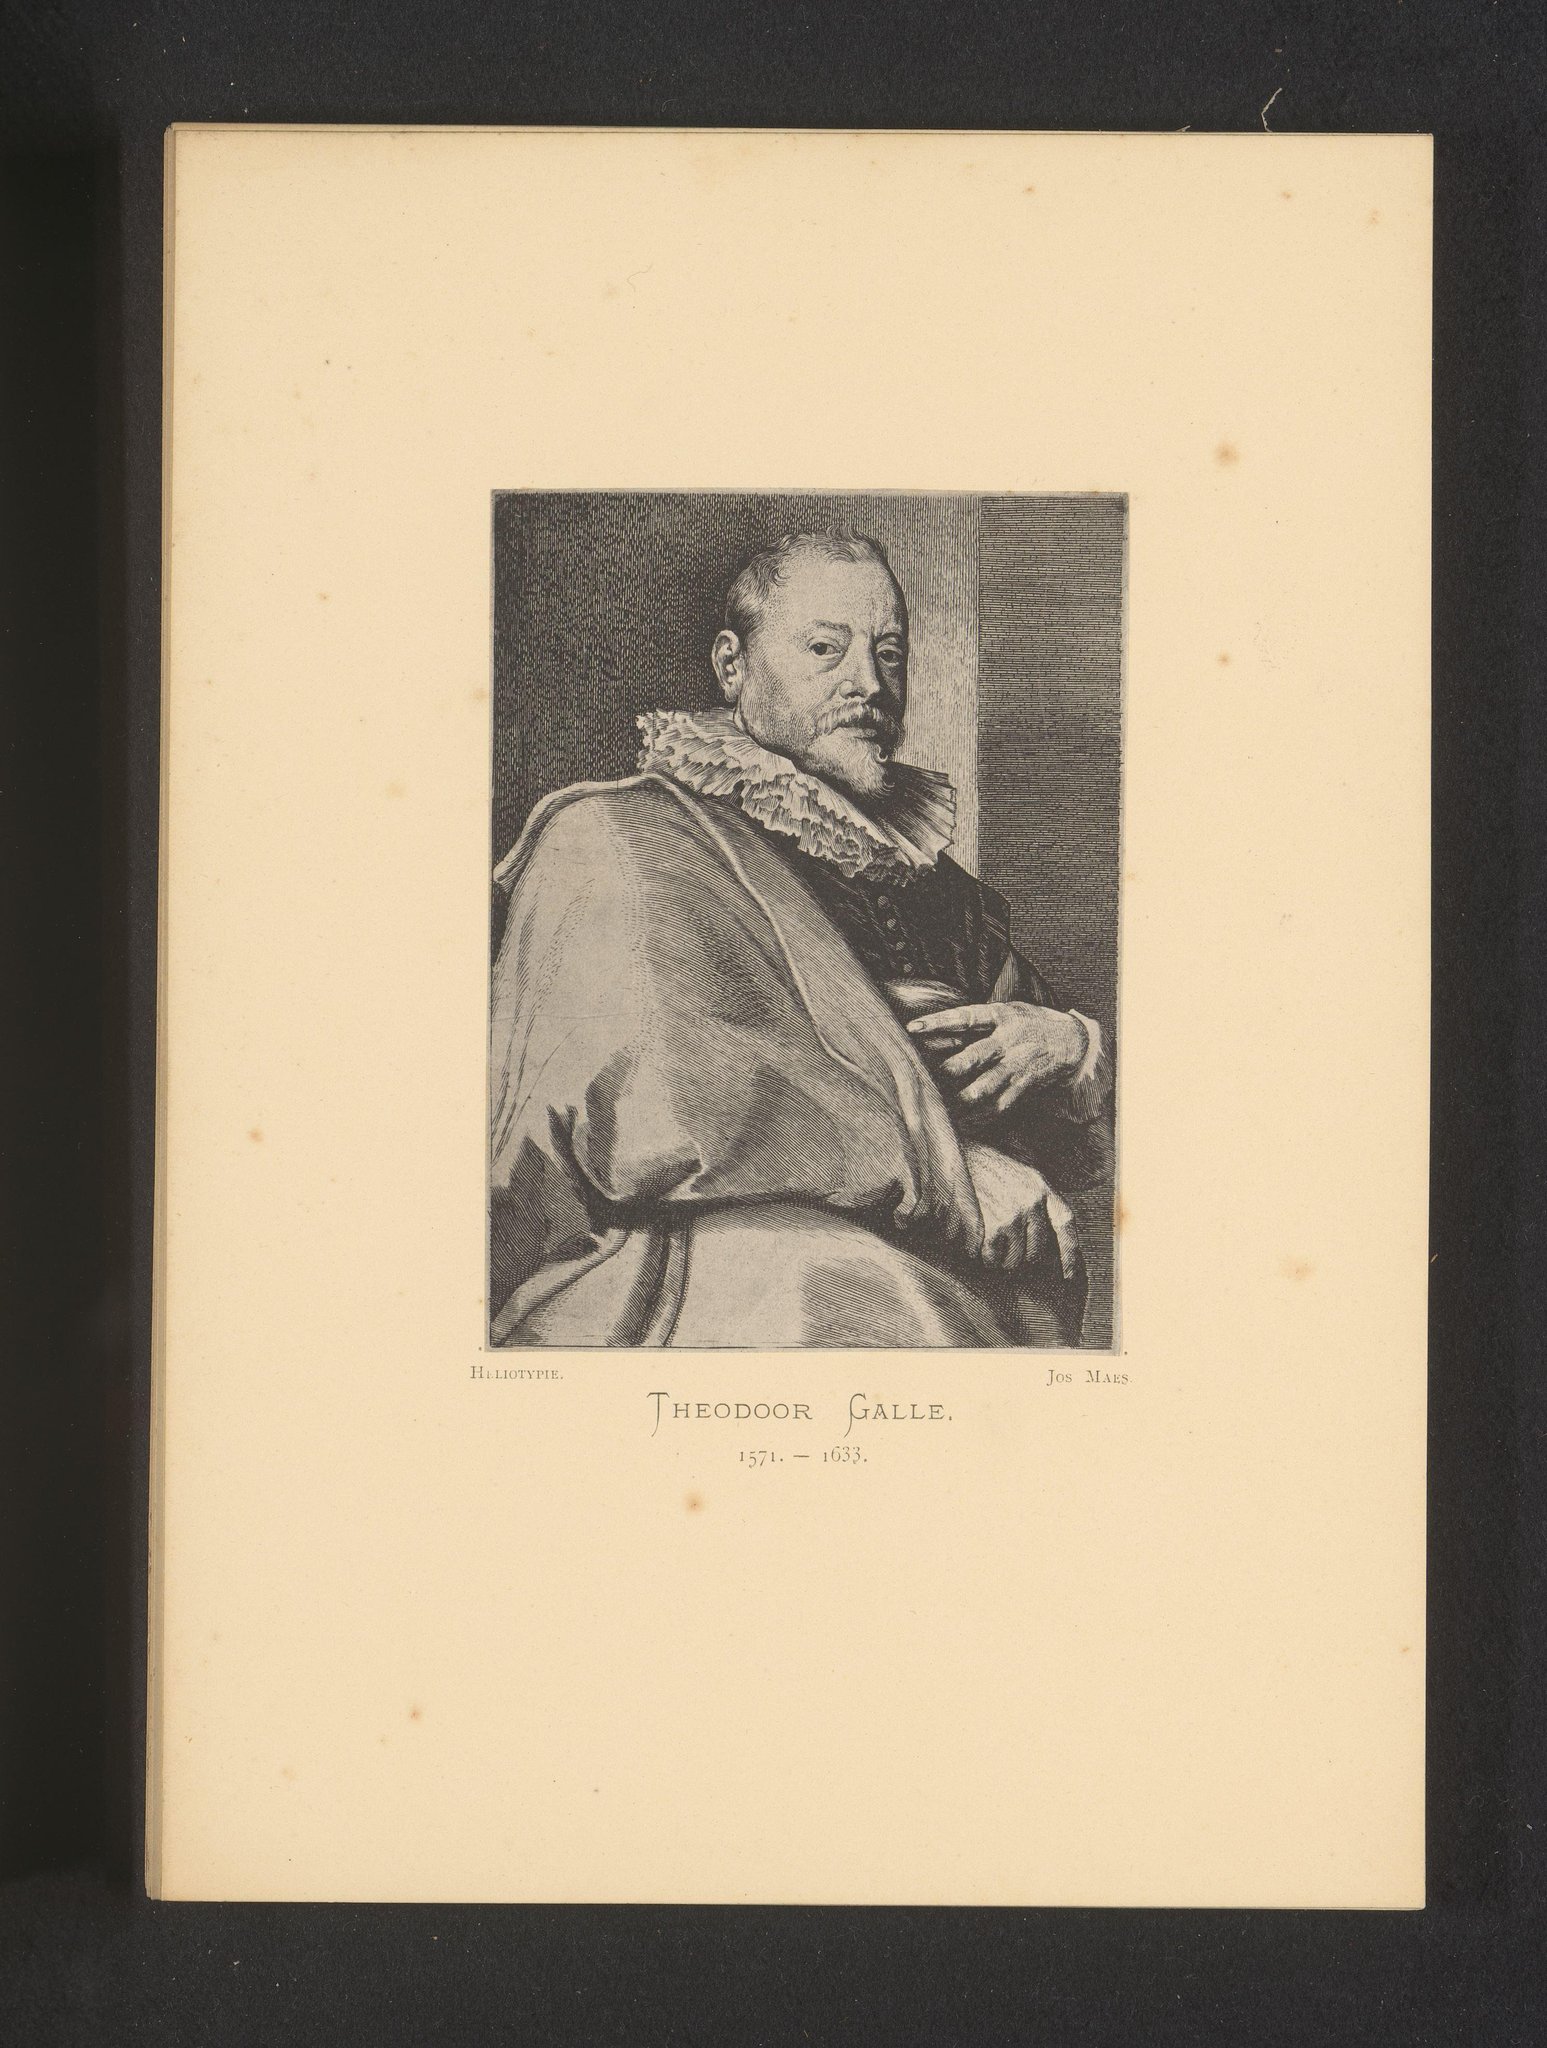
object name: photomechanical print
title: Theodoor Galle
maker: joseph maes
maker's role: fotograaf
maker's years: 1838-1908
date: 1872-1877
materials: cardboard, paper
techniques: photograph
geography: antwerp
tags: theodoor galle, historical persons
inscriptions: inscription: ‘1571. - 1633.’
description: Deze prent maakt deel uit van een omslag met 150 prenten en een katern met een lijst van afbeeldingen.